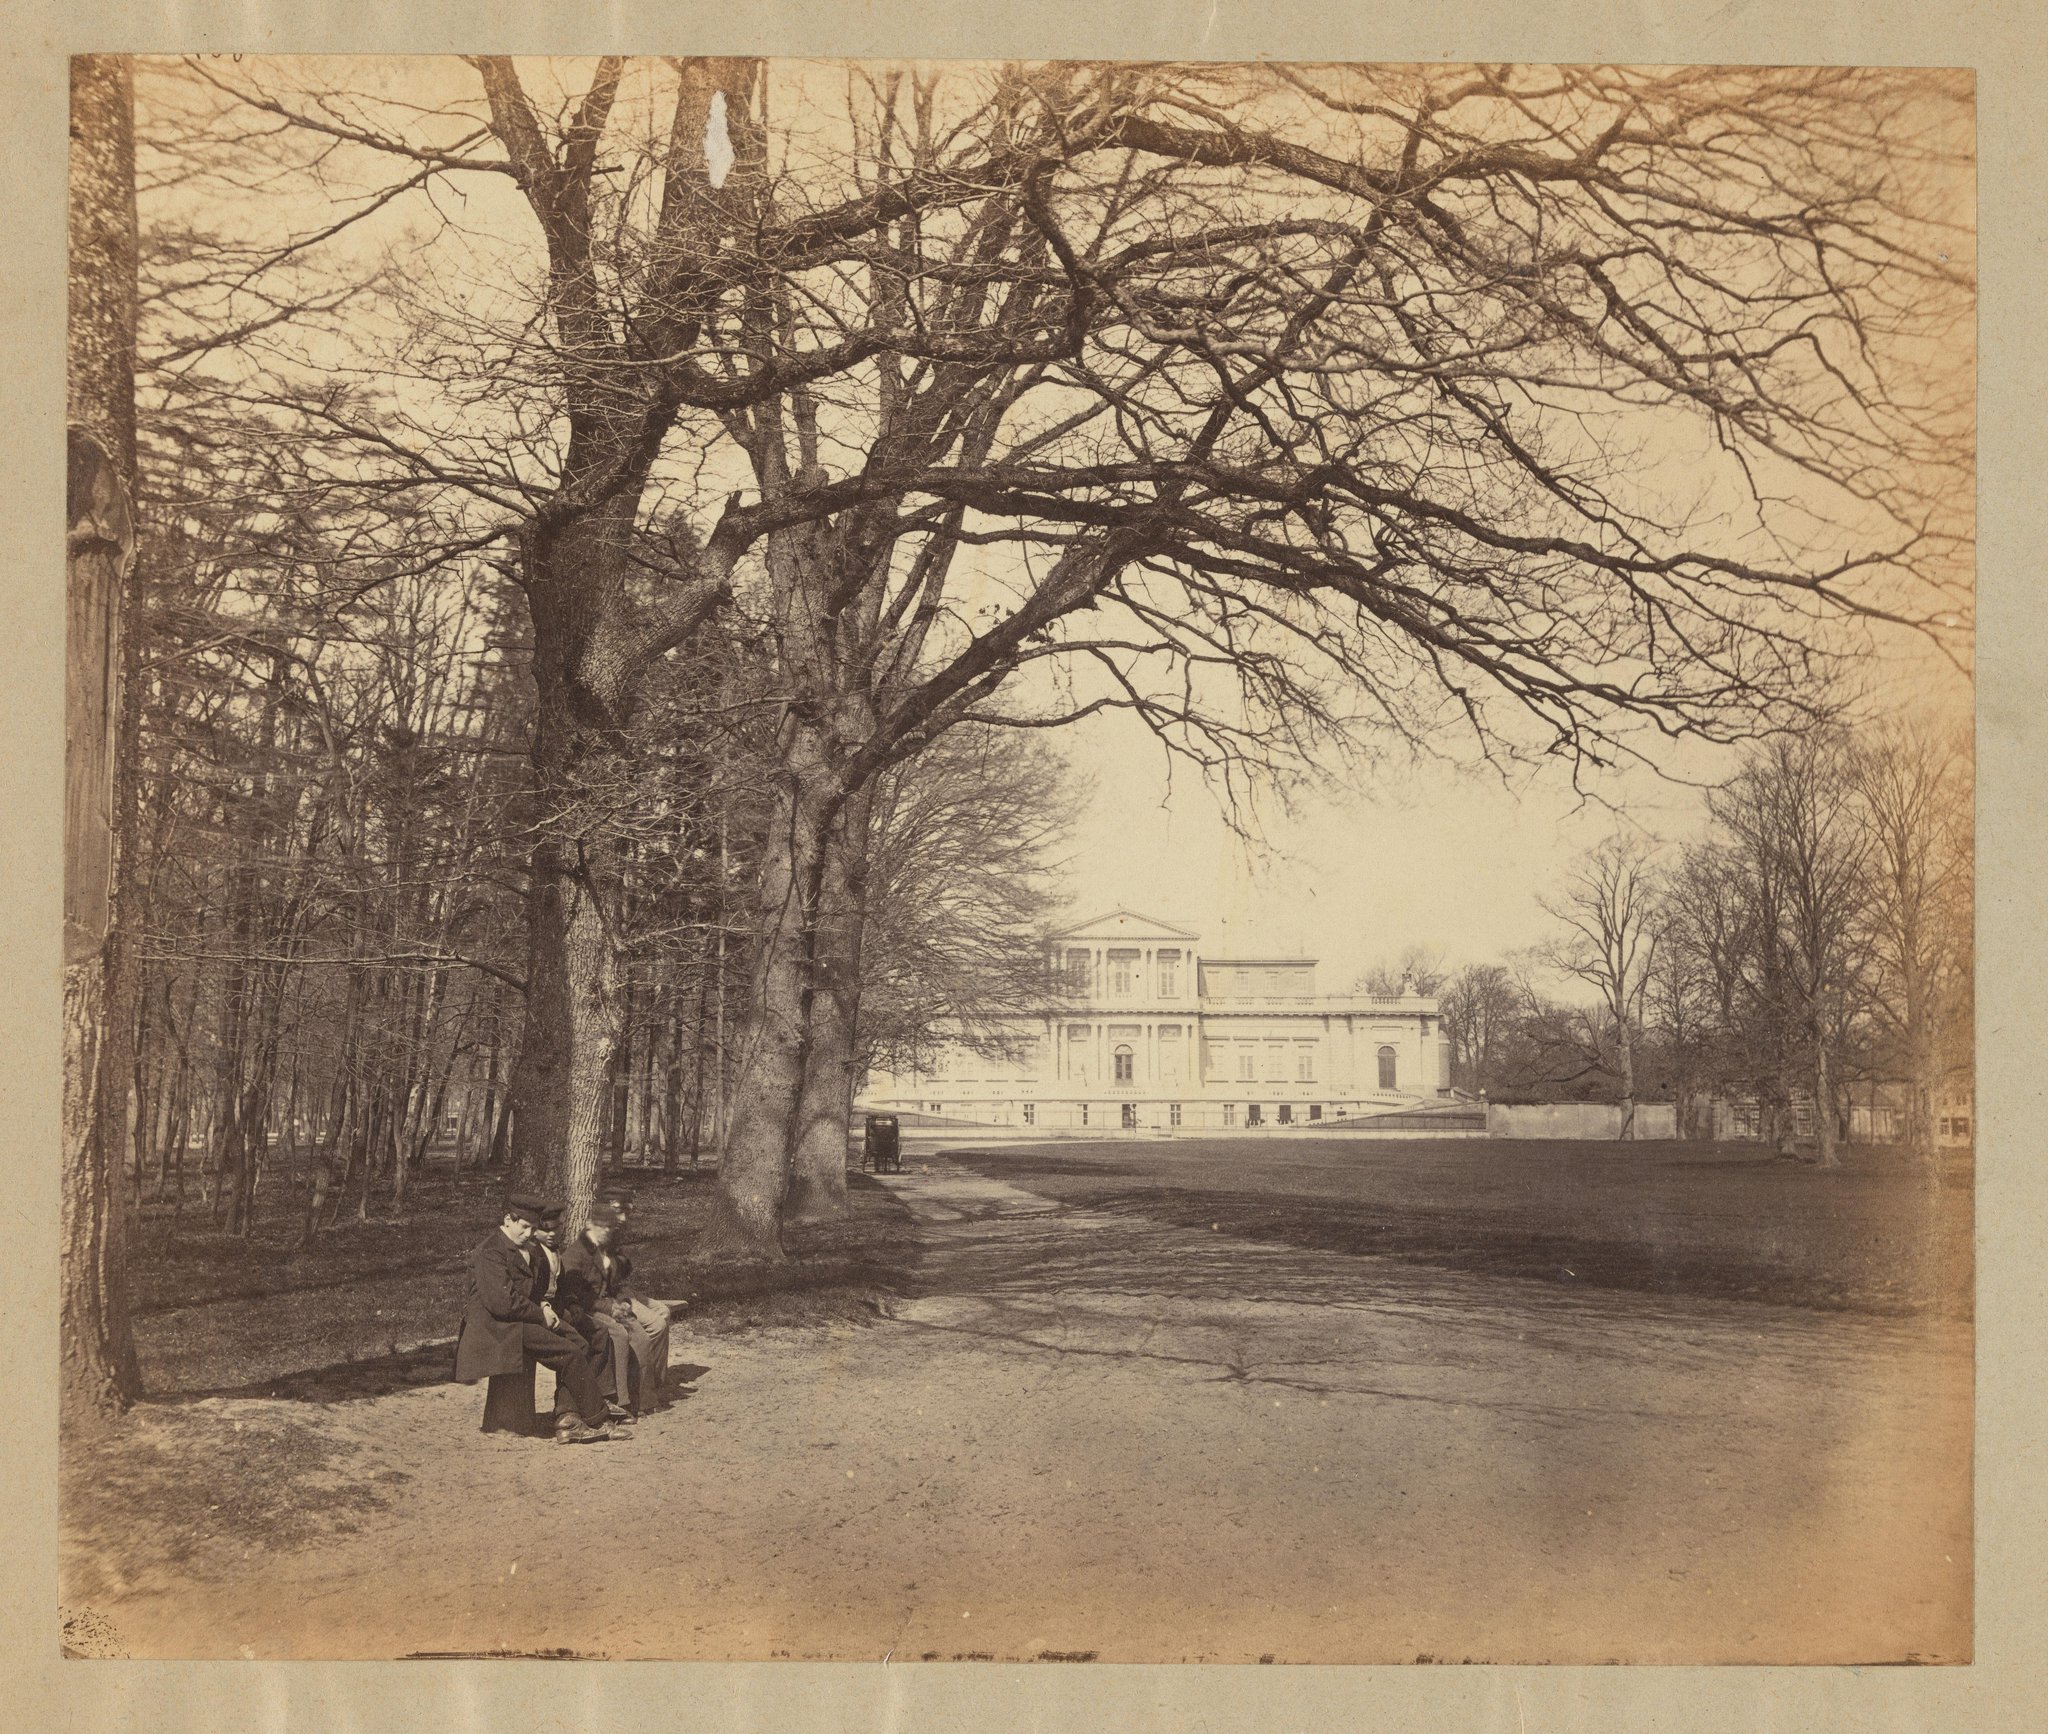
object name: photograph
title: Paviljoen Welgelegen, Haarlem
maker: gaston braun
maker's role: fotograaf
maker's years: 1845-1928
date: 1864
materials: photographic support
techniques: photography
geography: haarlem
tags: paviljoen welgelegen